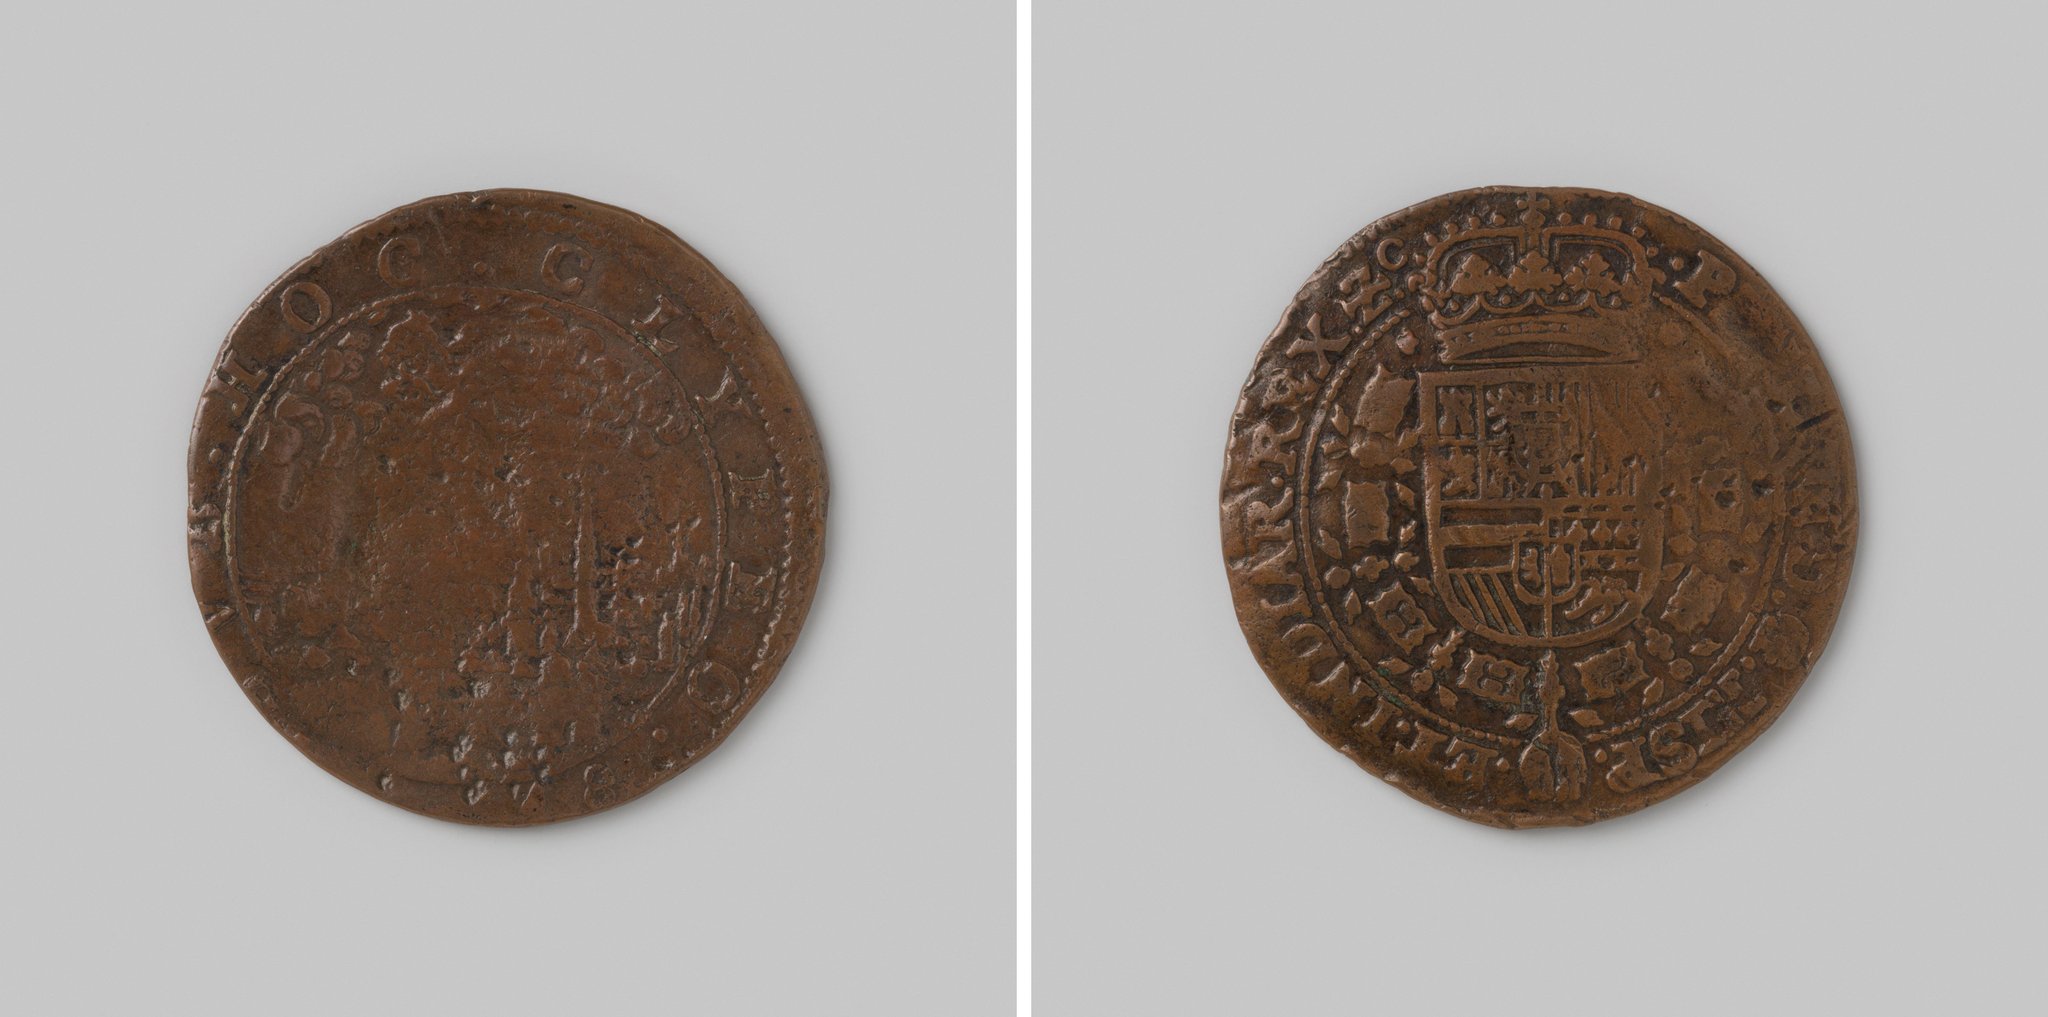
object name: jeton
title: Rekenpenning uit Antwerpen over de Vrede van Munster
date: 1648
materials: copper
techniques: striking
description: Koperen penning, op de voorzijde de stad Brussel waarboven een engel met het wapenschild van Munster, met omschrift, op de keerzijde het gekroonde Spaanse wapenschild omhangen met de keten van het Gulden Vlies, met omschrift.